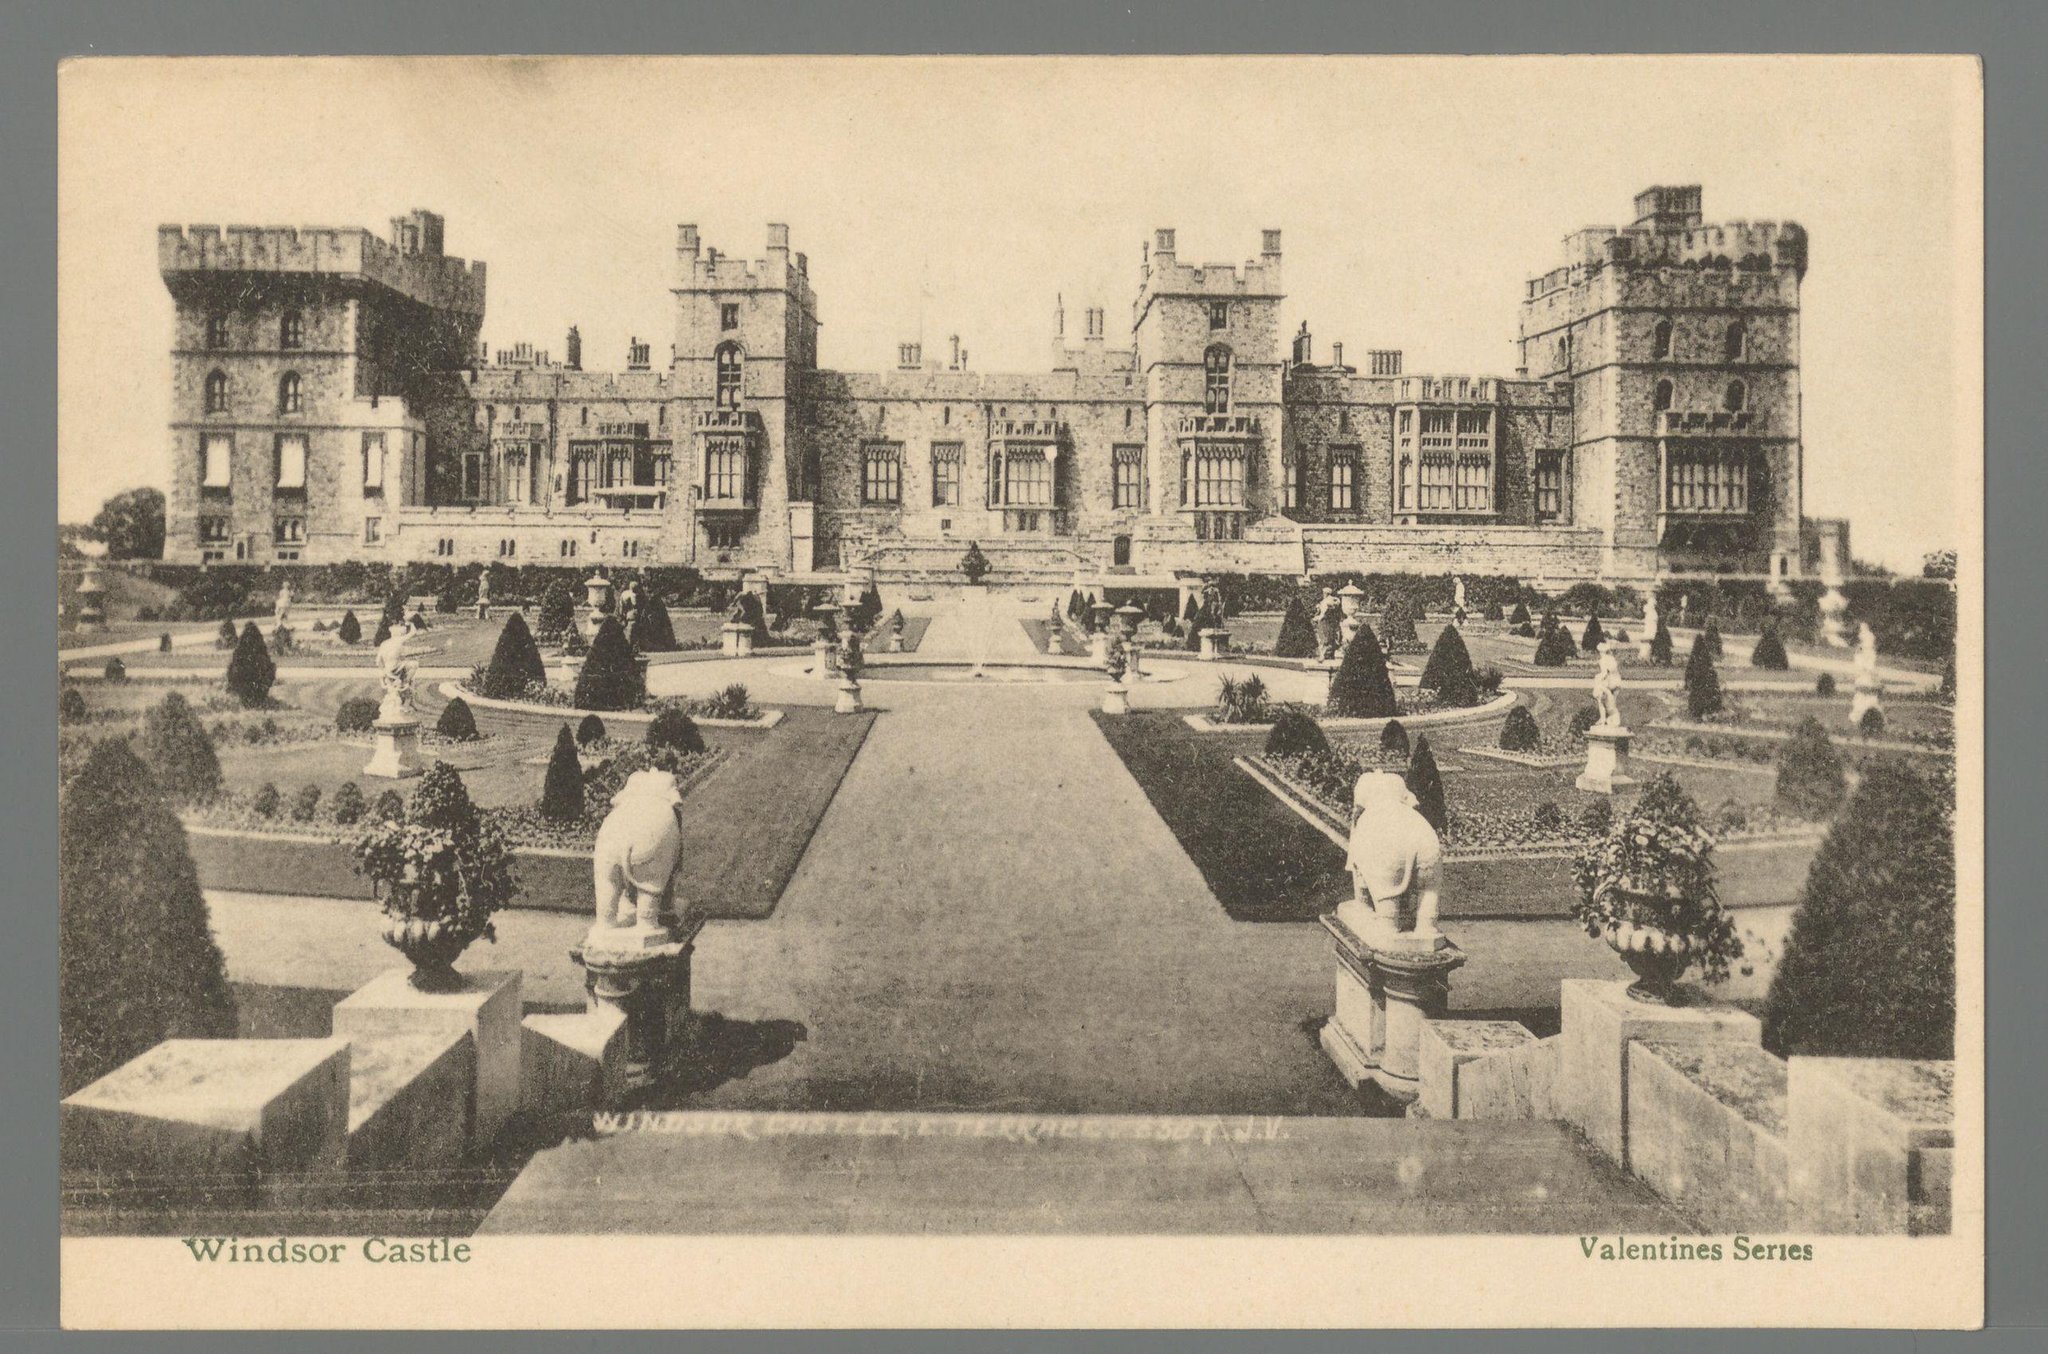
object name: ansichtkaart, prentbriefkaart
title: Windsor Castle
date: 1902-1930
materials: cardboard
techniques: photograph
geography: windsor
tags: castle, garden